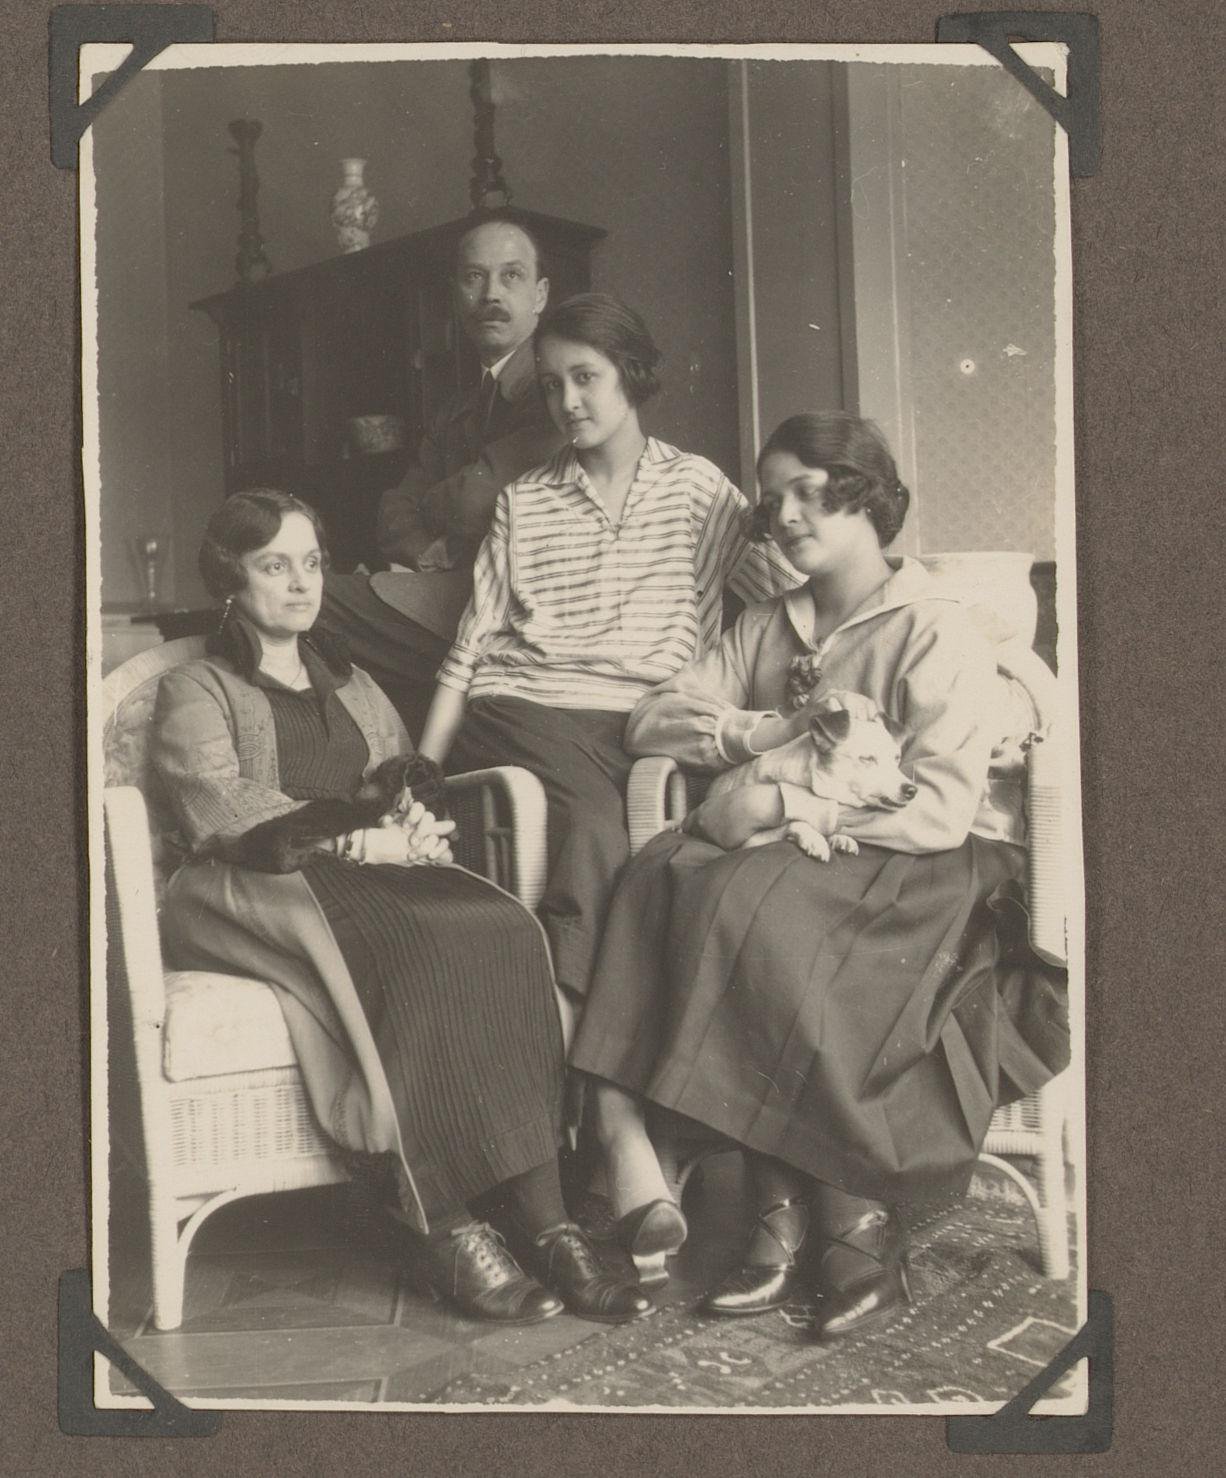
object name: album leaf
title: Henriëtte Wassink, Meinard Dorus Mijer, Dootje en Wilhelmina van Zijll de Jong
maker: Anonymous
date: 1930-1935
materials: paper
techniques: gelatin silver print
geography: dutch east indies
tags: batavia, henriëtte wassink, wilhelmina van zijll de jong, family group, especially parents with their child(ren), dutch east indies, the